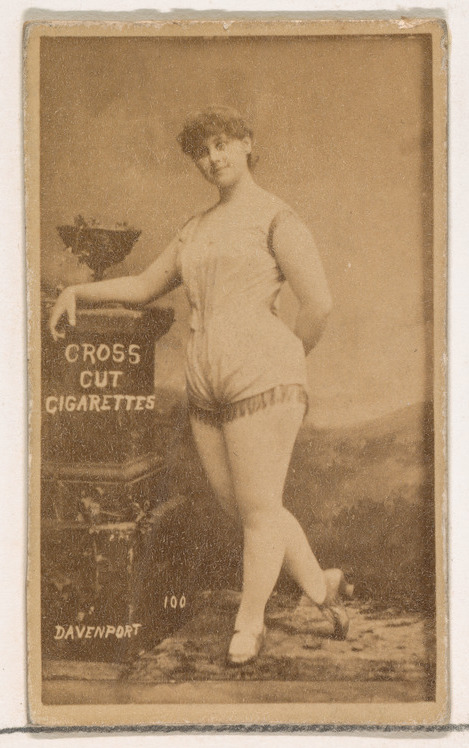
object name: print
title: Card Number 100, Davenport, from the Actors and Actresses series (N145-1) issued by Duke Sons & Co. to promote Cross Cut Cigarettes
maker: w. duke, sons & co.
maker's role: publisher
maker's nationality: american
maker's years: 1870-1920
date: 1880-1889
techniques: albumen silver print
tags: portraits,women,actresses